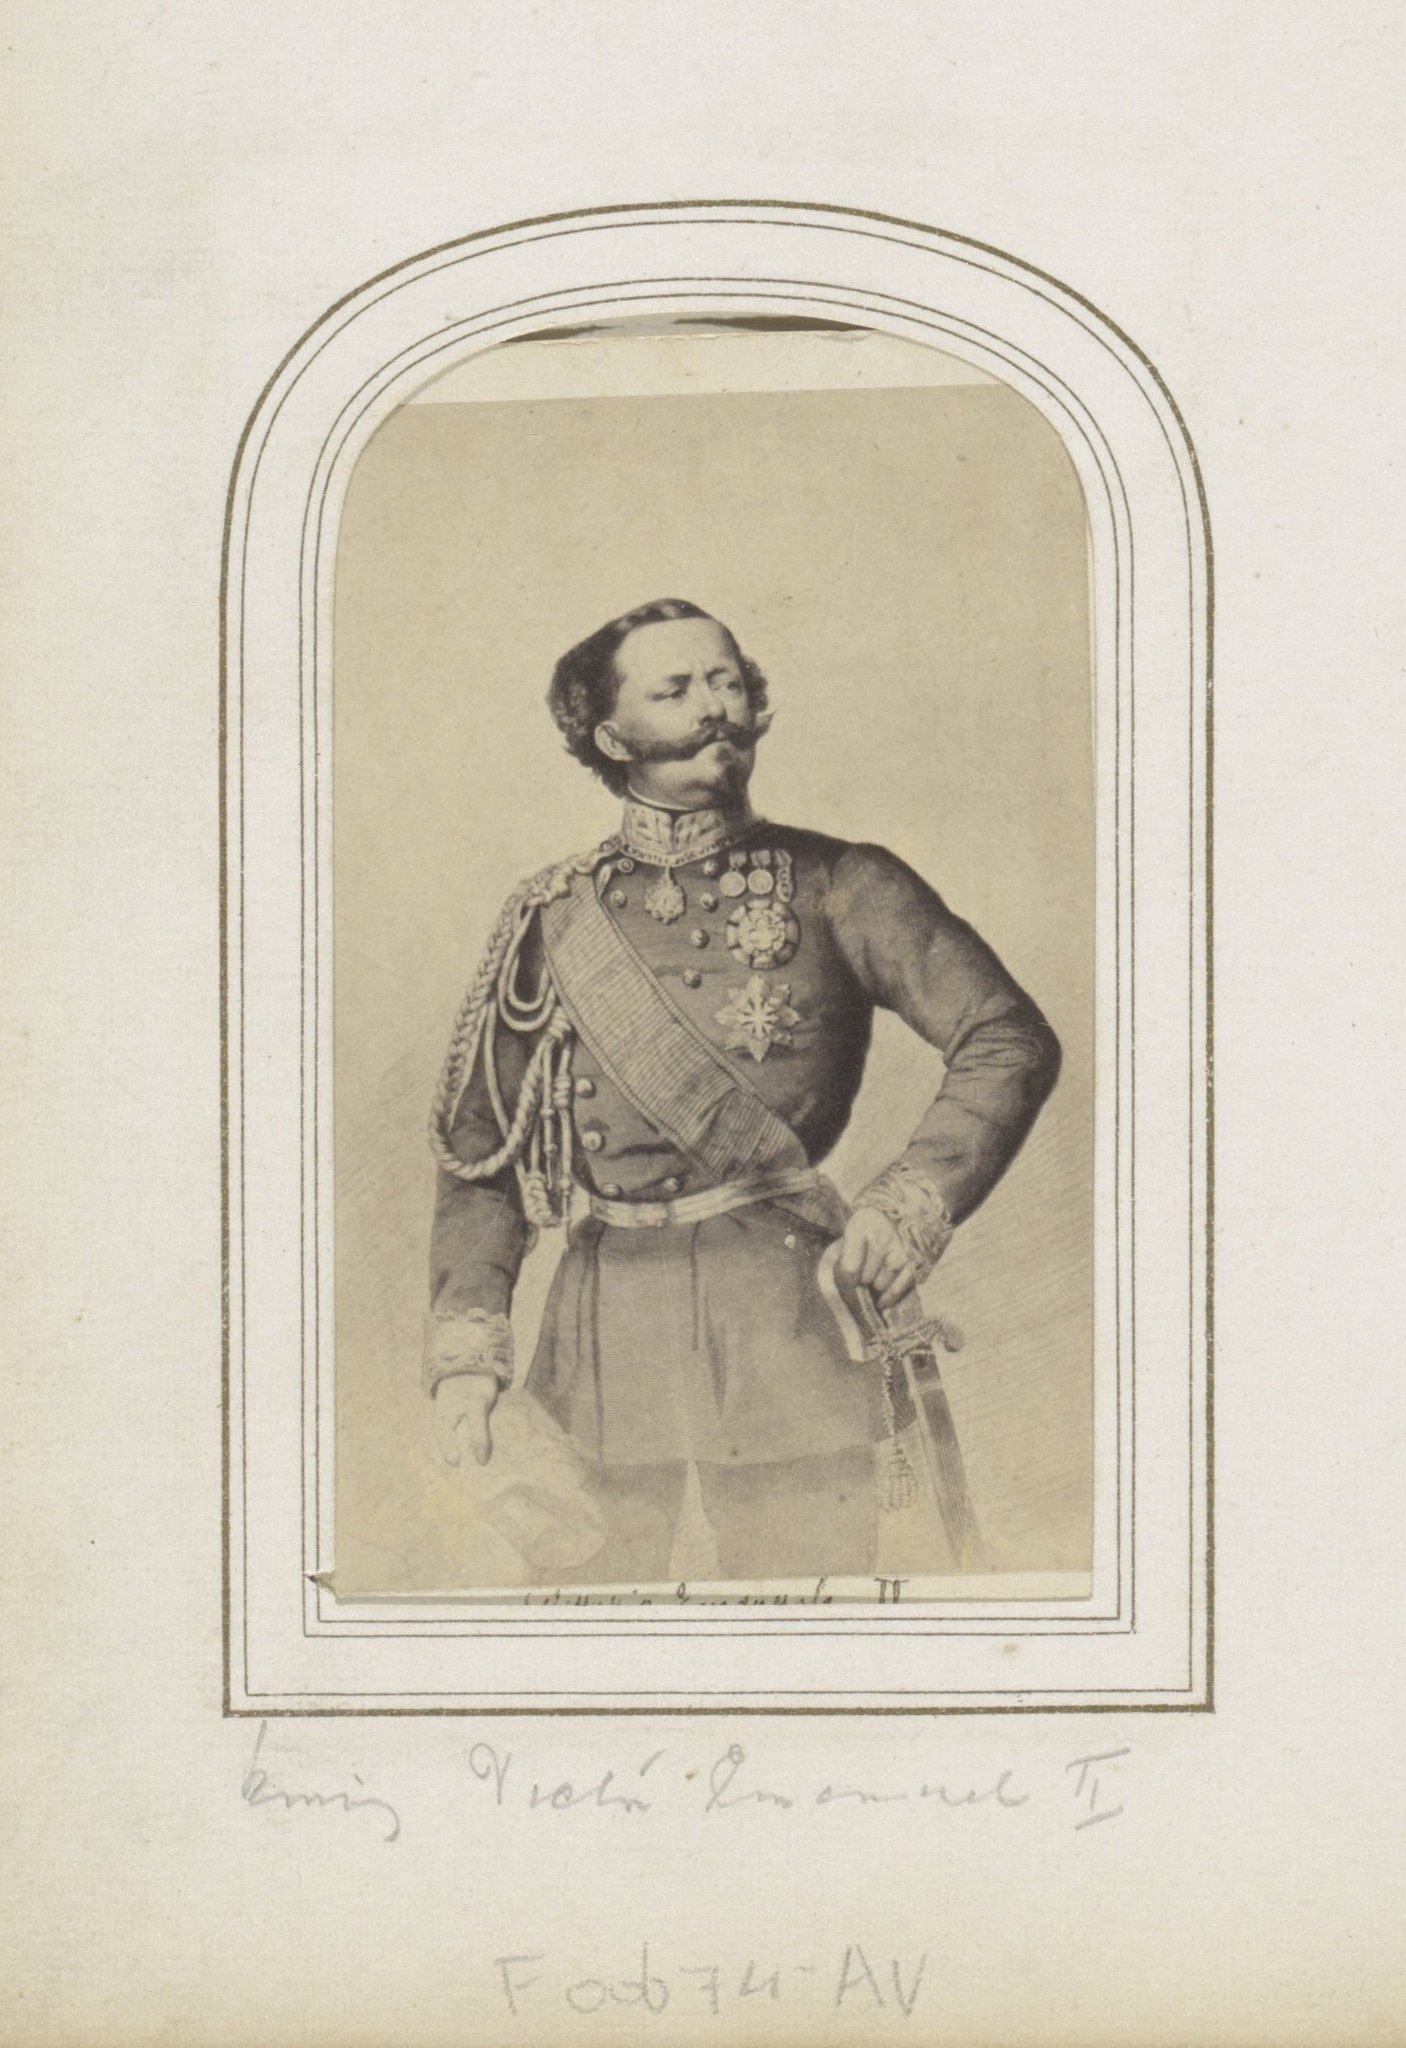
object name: reproduction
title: Fotoreproductie van (vermoedelijk) een prent van Victor Emanuel II, koning van Italië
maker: Anonymous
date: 1862-1880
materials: cardboard, paper, photographic support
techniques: albumen print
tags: rome, hacking and thrusting weapons (with name), moustache, historical persons, head-gear: hat (+ men's clothes), ruler, sovereign, decorations, honours (as symbols of the state, etc.), (military) uniforms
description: Onderdeel van Fotoalbum met 123 cartes-de-visite van leden van Europese vorstenhuizen, politici en bekende personen.